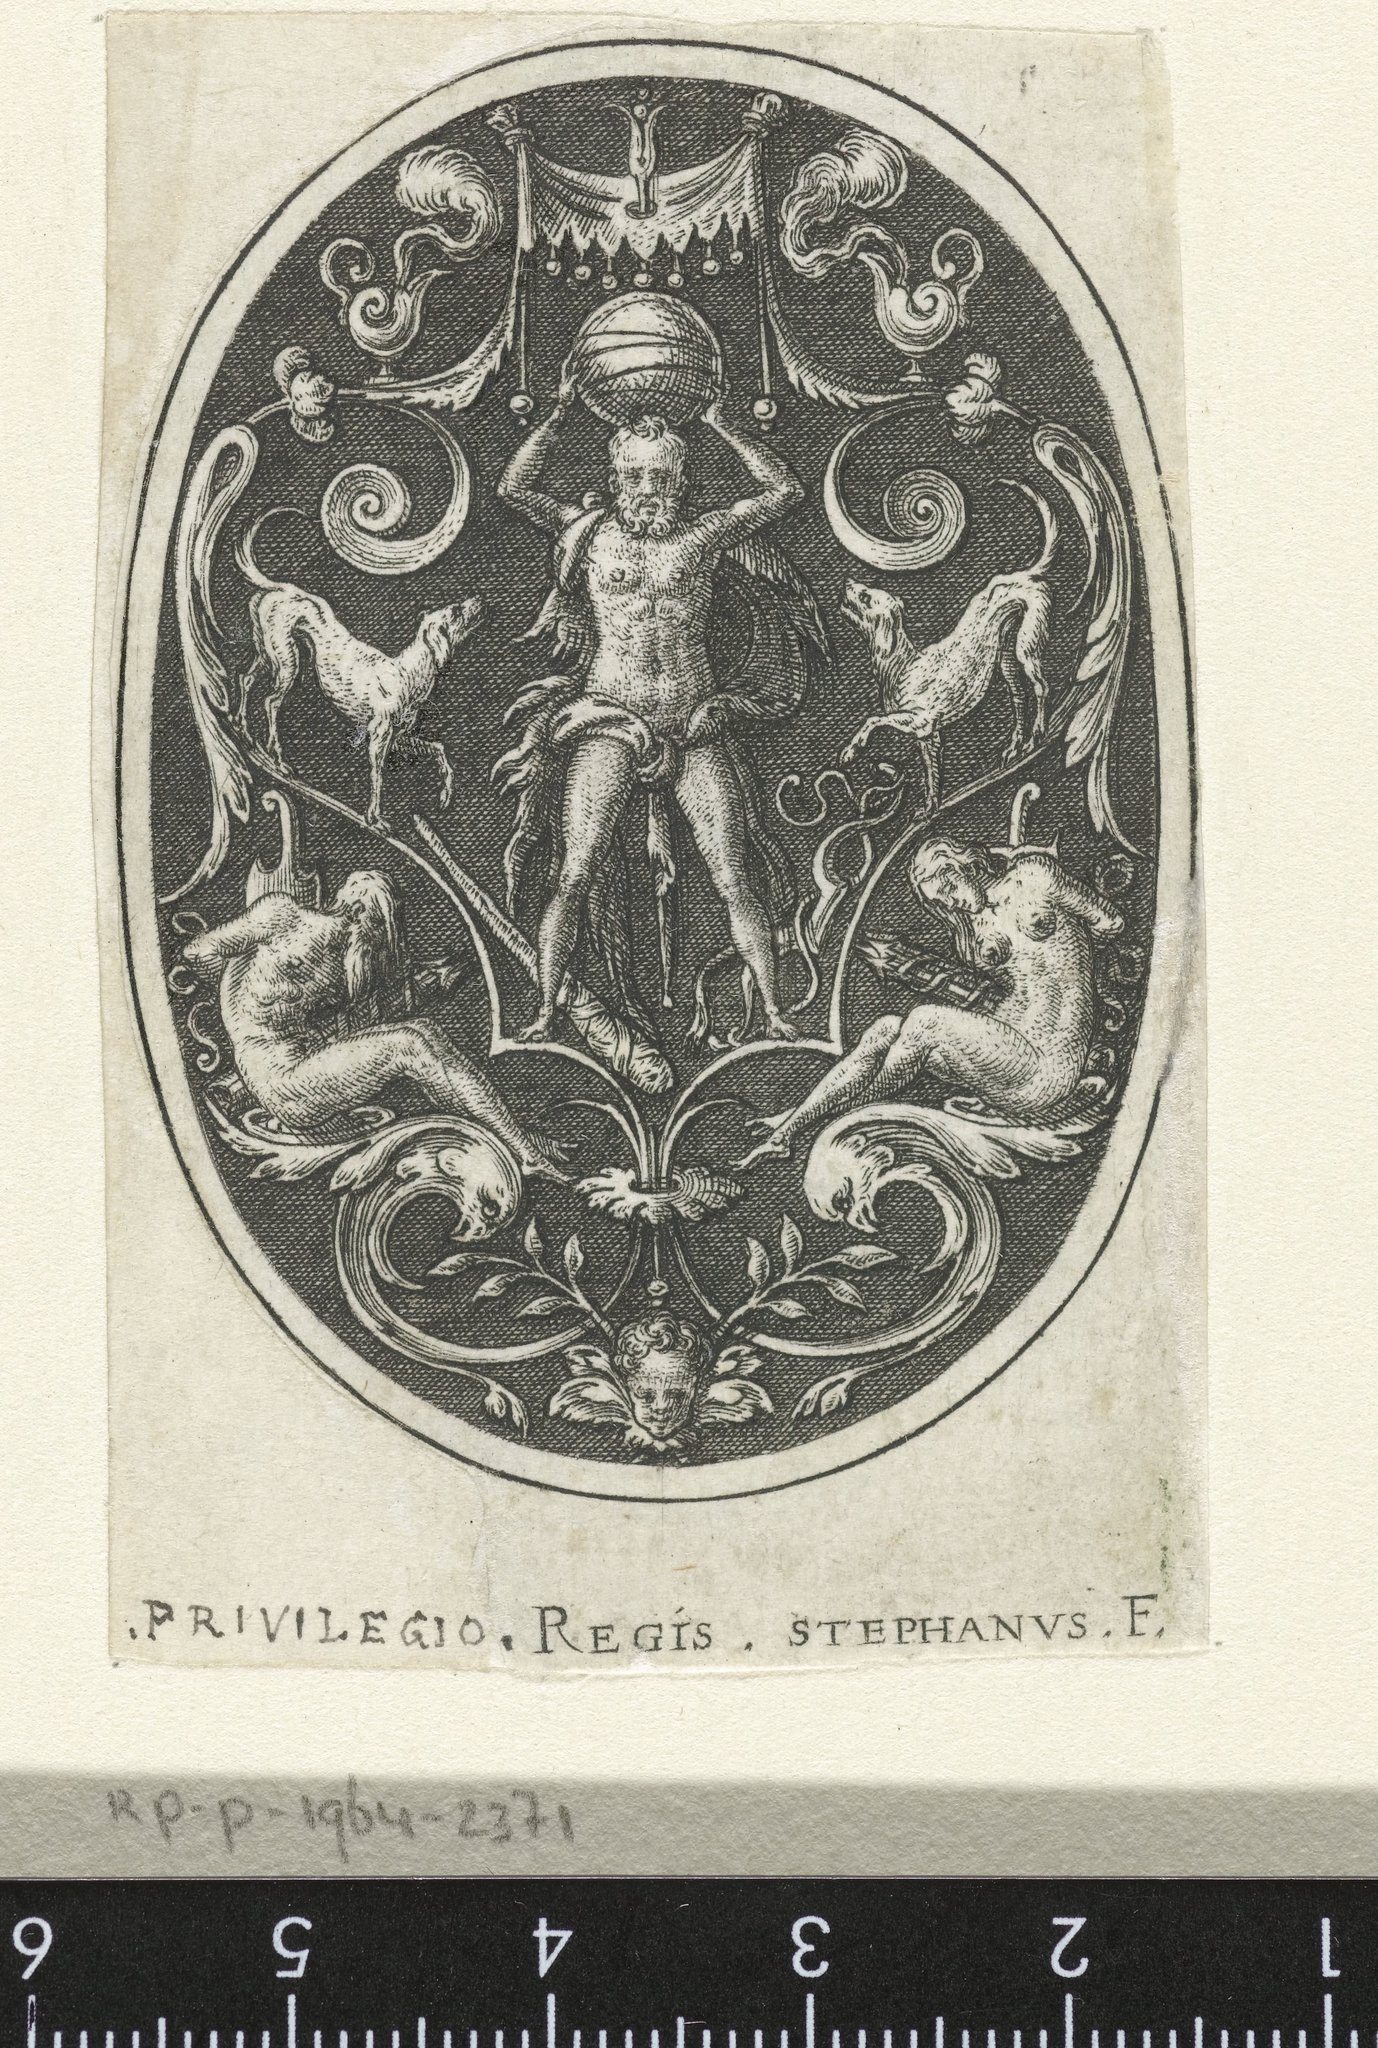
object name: ornament print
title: Hercules met de aardbol op zijn hoofd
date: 1528-1583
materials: paper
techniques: engraving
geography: france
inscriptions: inscription: ‘PRIVILEGIO’